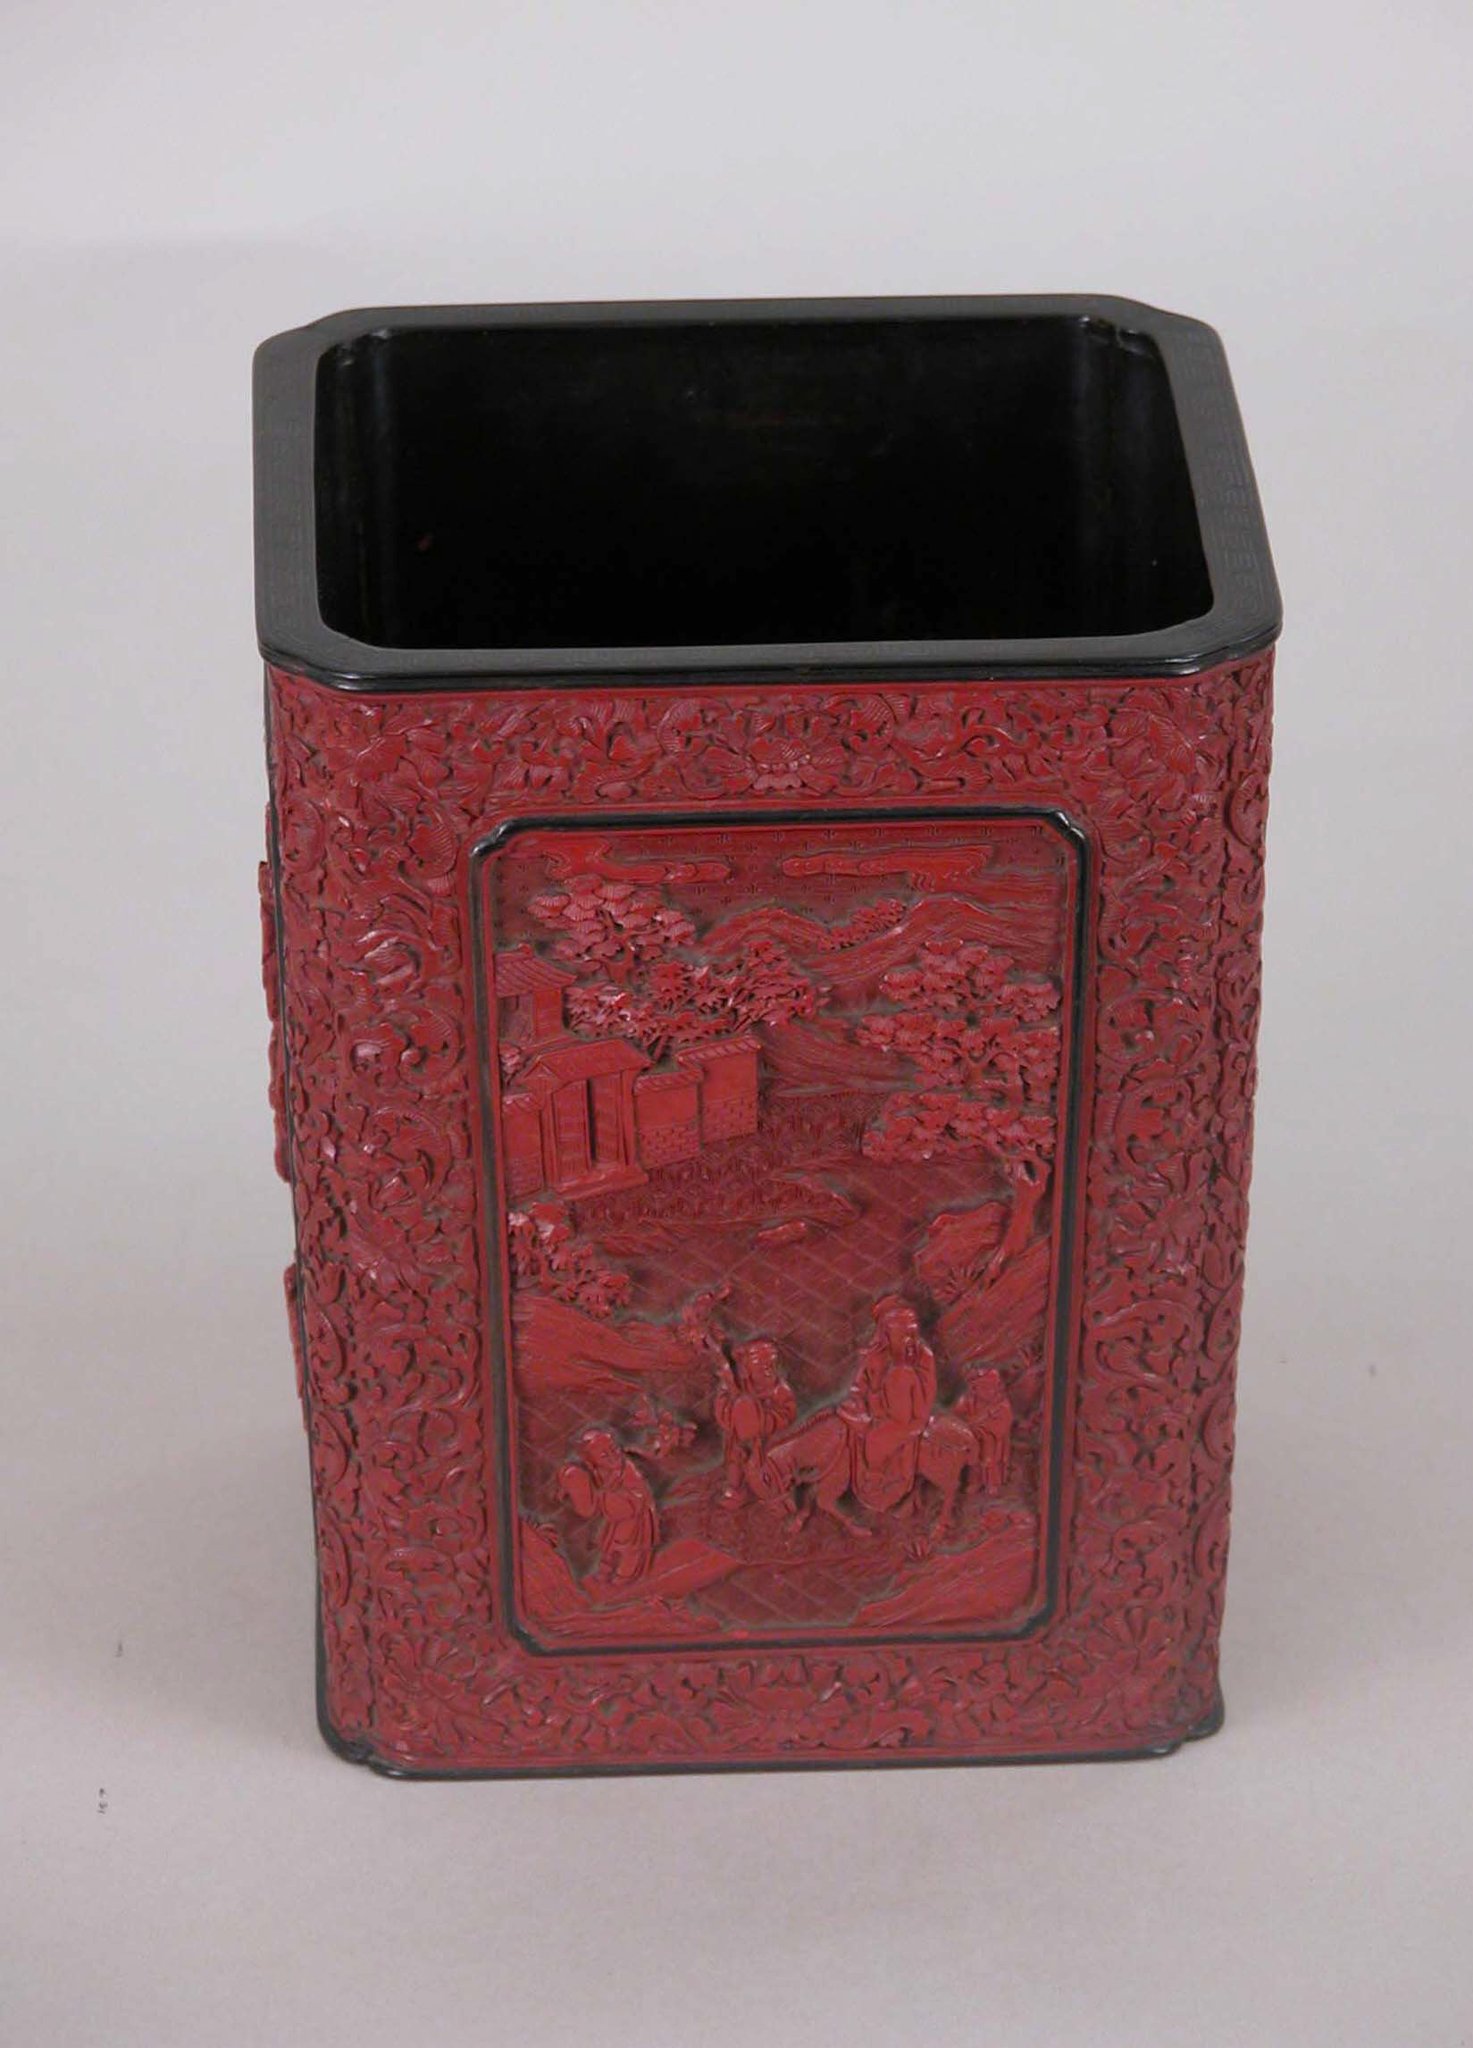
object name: brush holder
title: Brush holder with scholars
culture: chinese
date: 1701-1900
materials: lacquer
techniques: carving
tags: human figures,buildings,horses